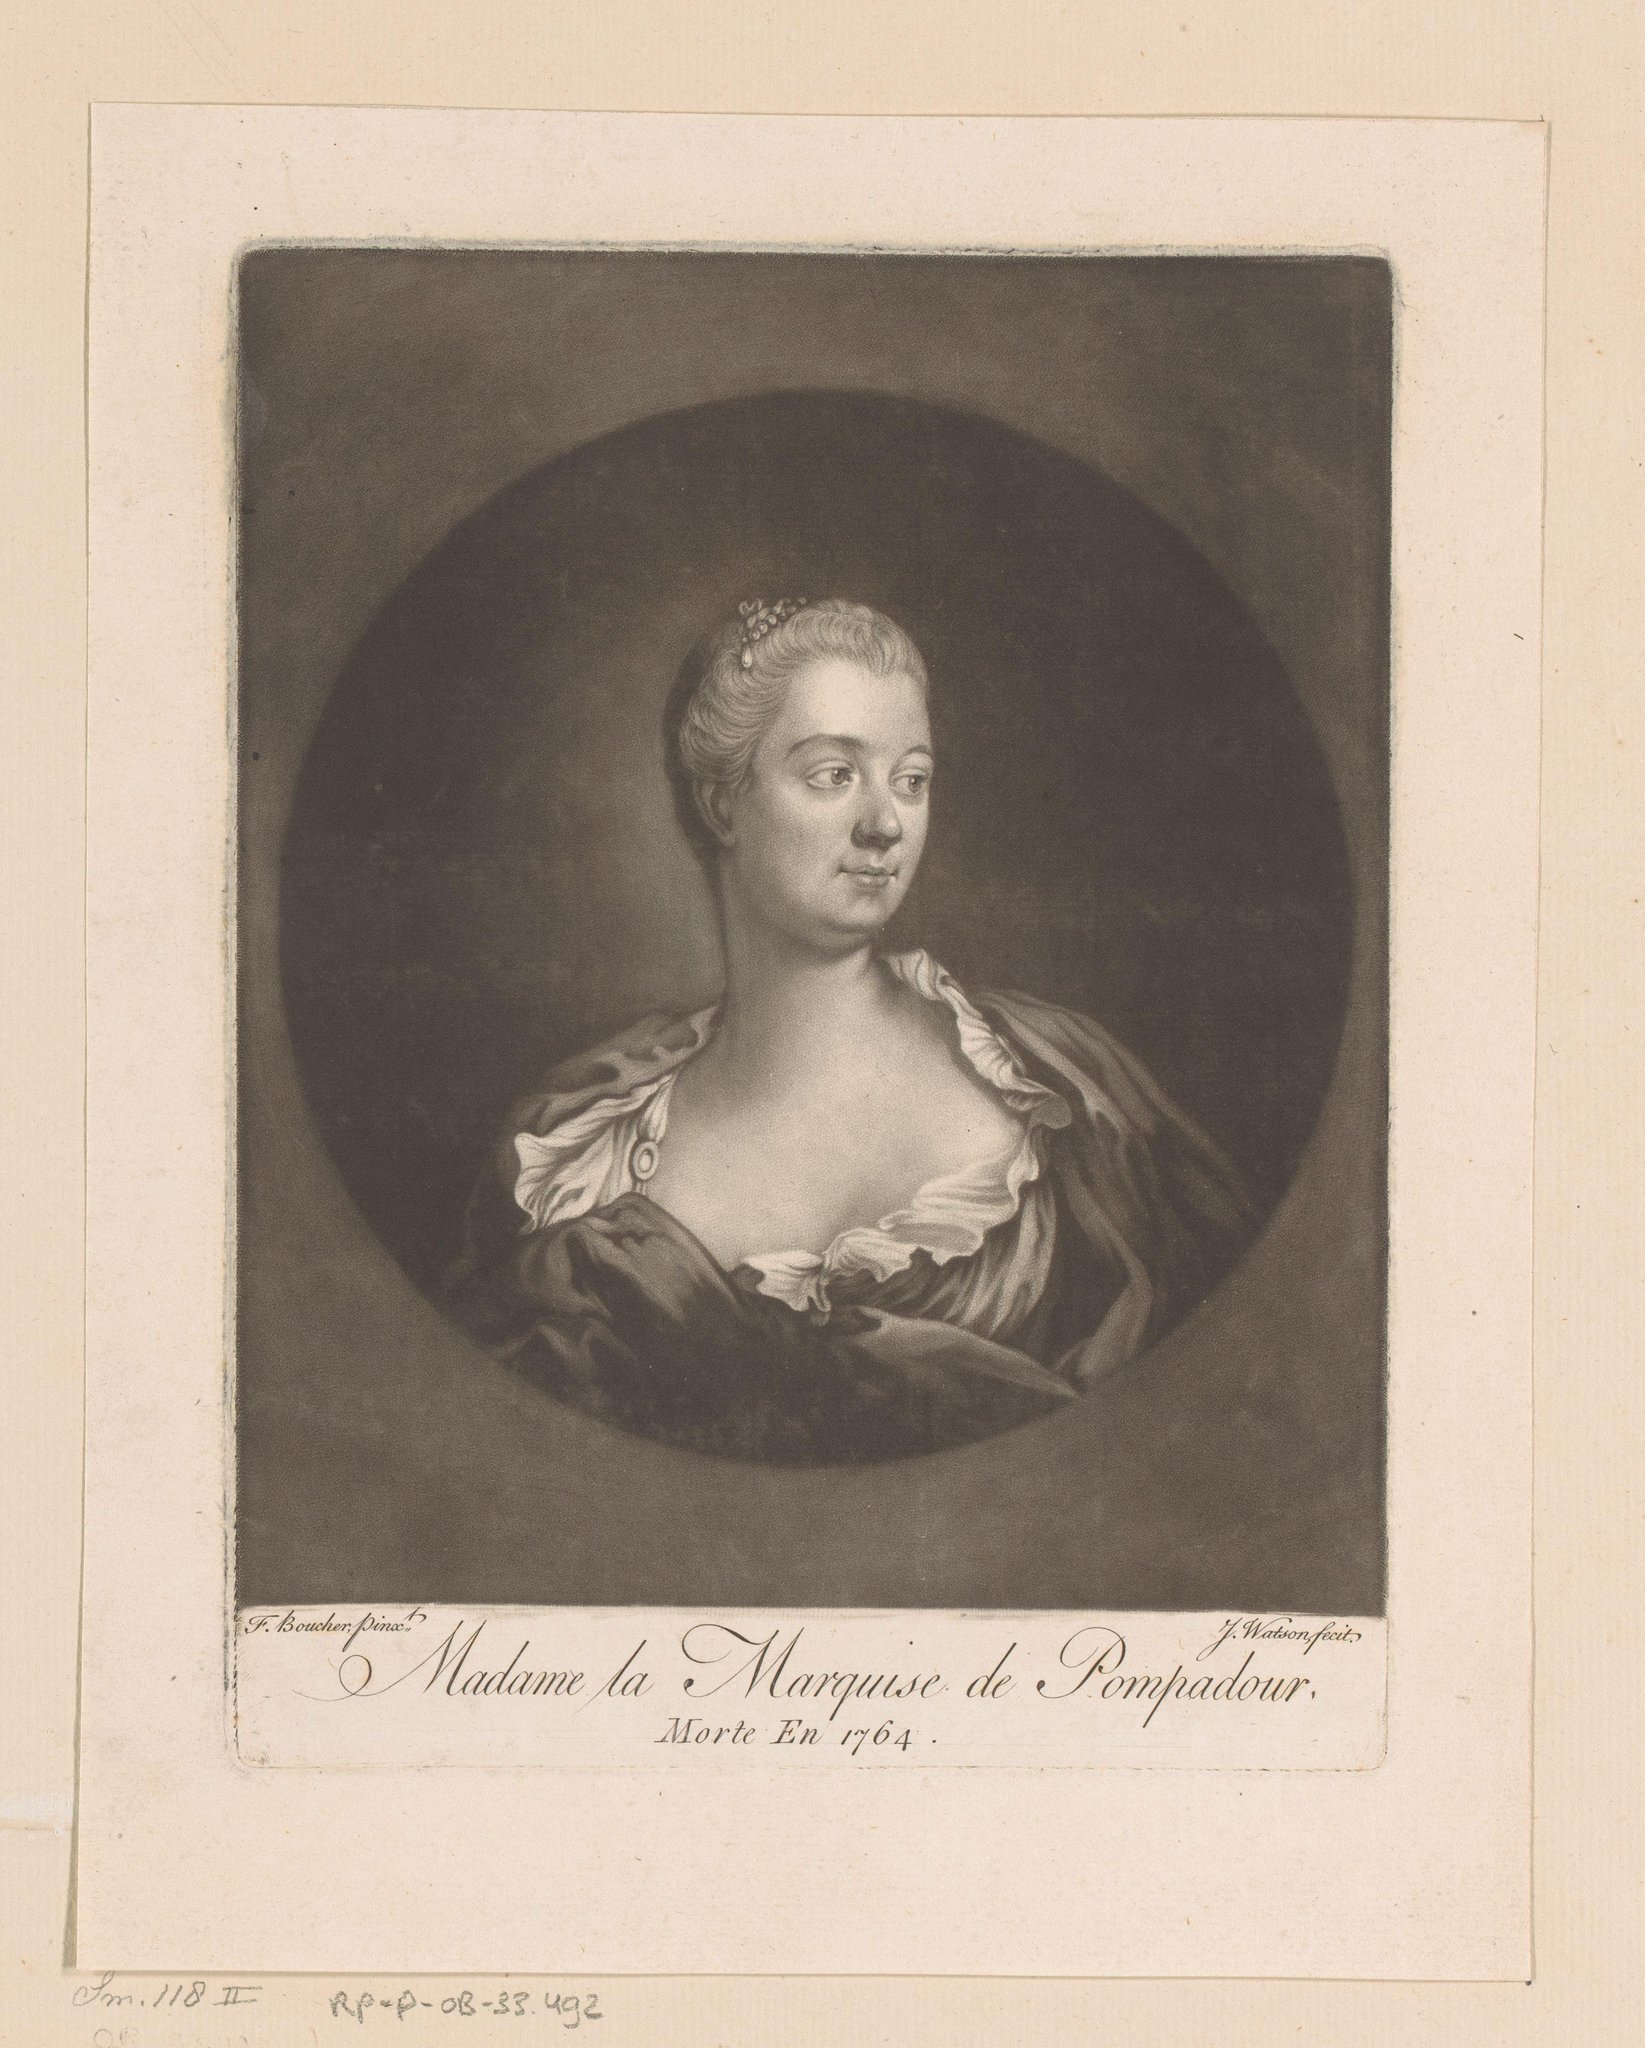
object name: print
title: Madame la Marquise de Pompadour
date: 1765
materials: paper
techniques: mezzotint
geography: london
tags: paris, print maker, madame de pompadour, historical persons - bb - woman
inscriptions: collector's mark: Lugt 240